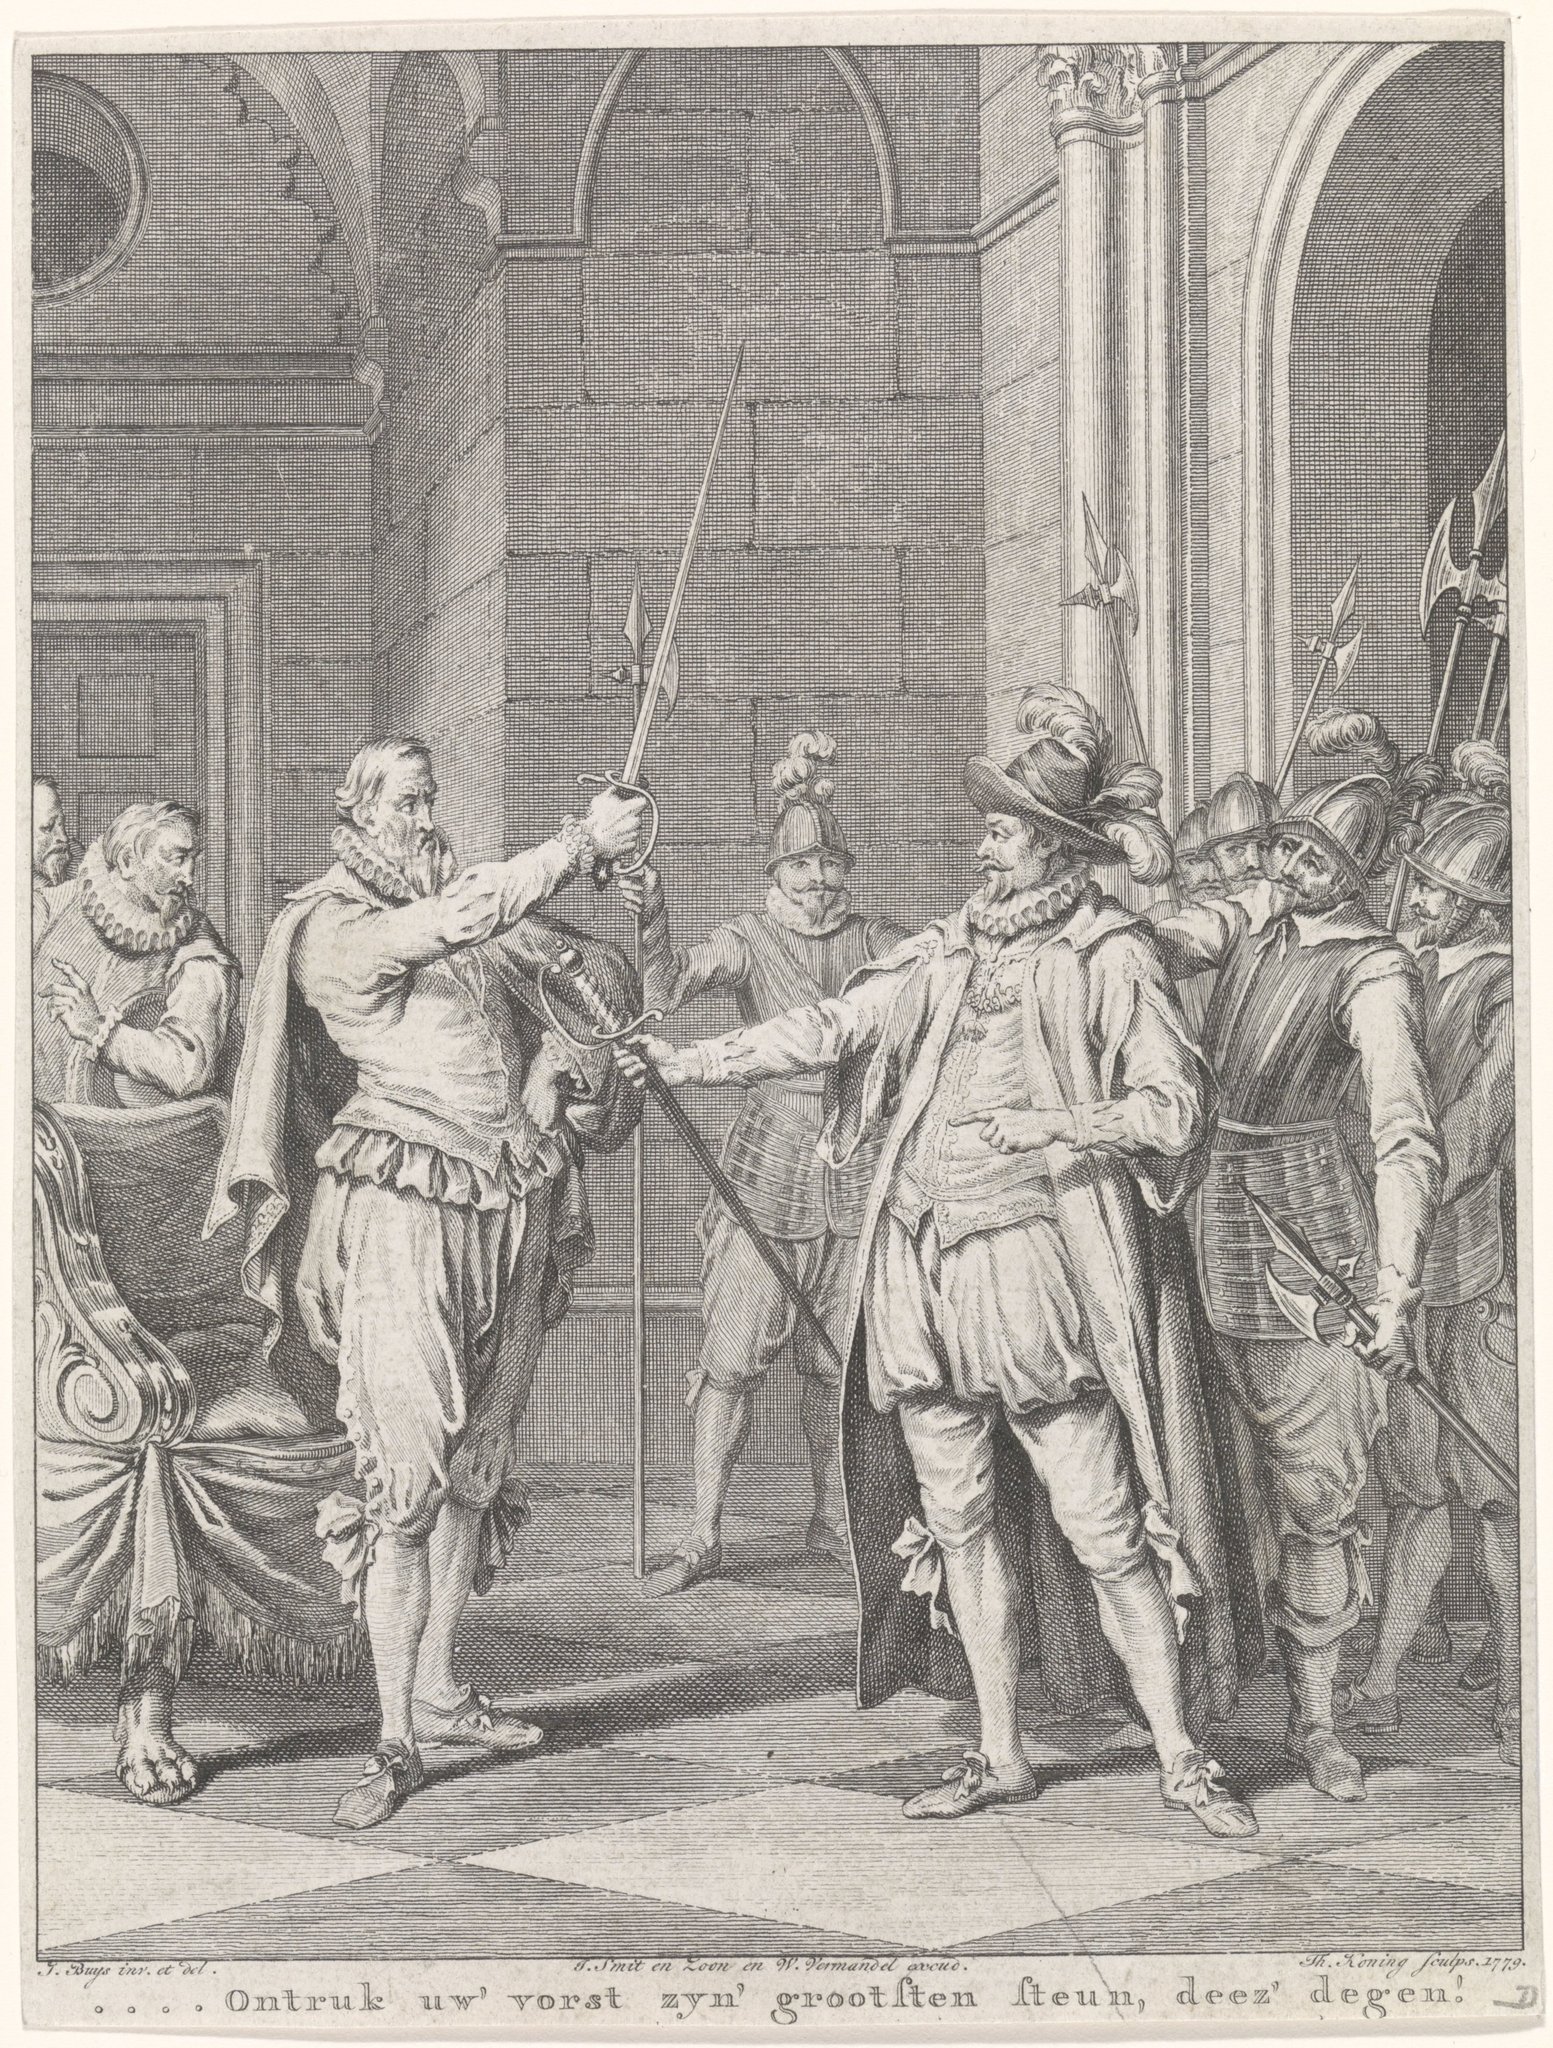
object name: print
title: Taferelen uit het leven van prins Willem I, 1568-1584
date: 1779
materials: paper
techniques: engraving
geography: amsterdam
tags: fernando álvarez de toledo (3rd duke of alba), brussels, earl, law and jurisprudence (+ arrest)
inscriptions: collector's mark: Lugt 2228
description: Bij zijn arrestatie op 10 september 1567 overhandigt de graaf van Egmond zijn zwaard aan Alva. Deze prent maakt deel uit van een serie van 24 prenten met taferelen uit het leven van prins Willem I, 1568-1584. Deze prent is een illustratie bij de tweede zang.